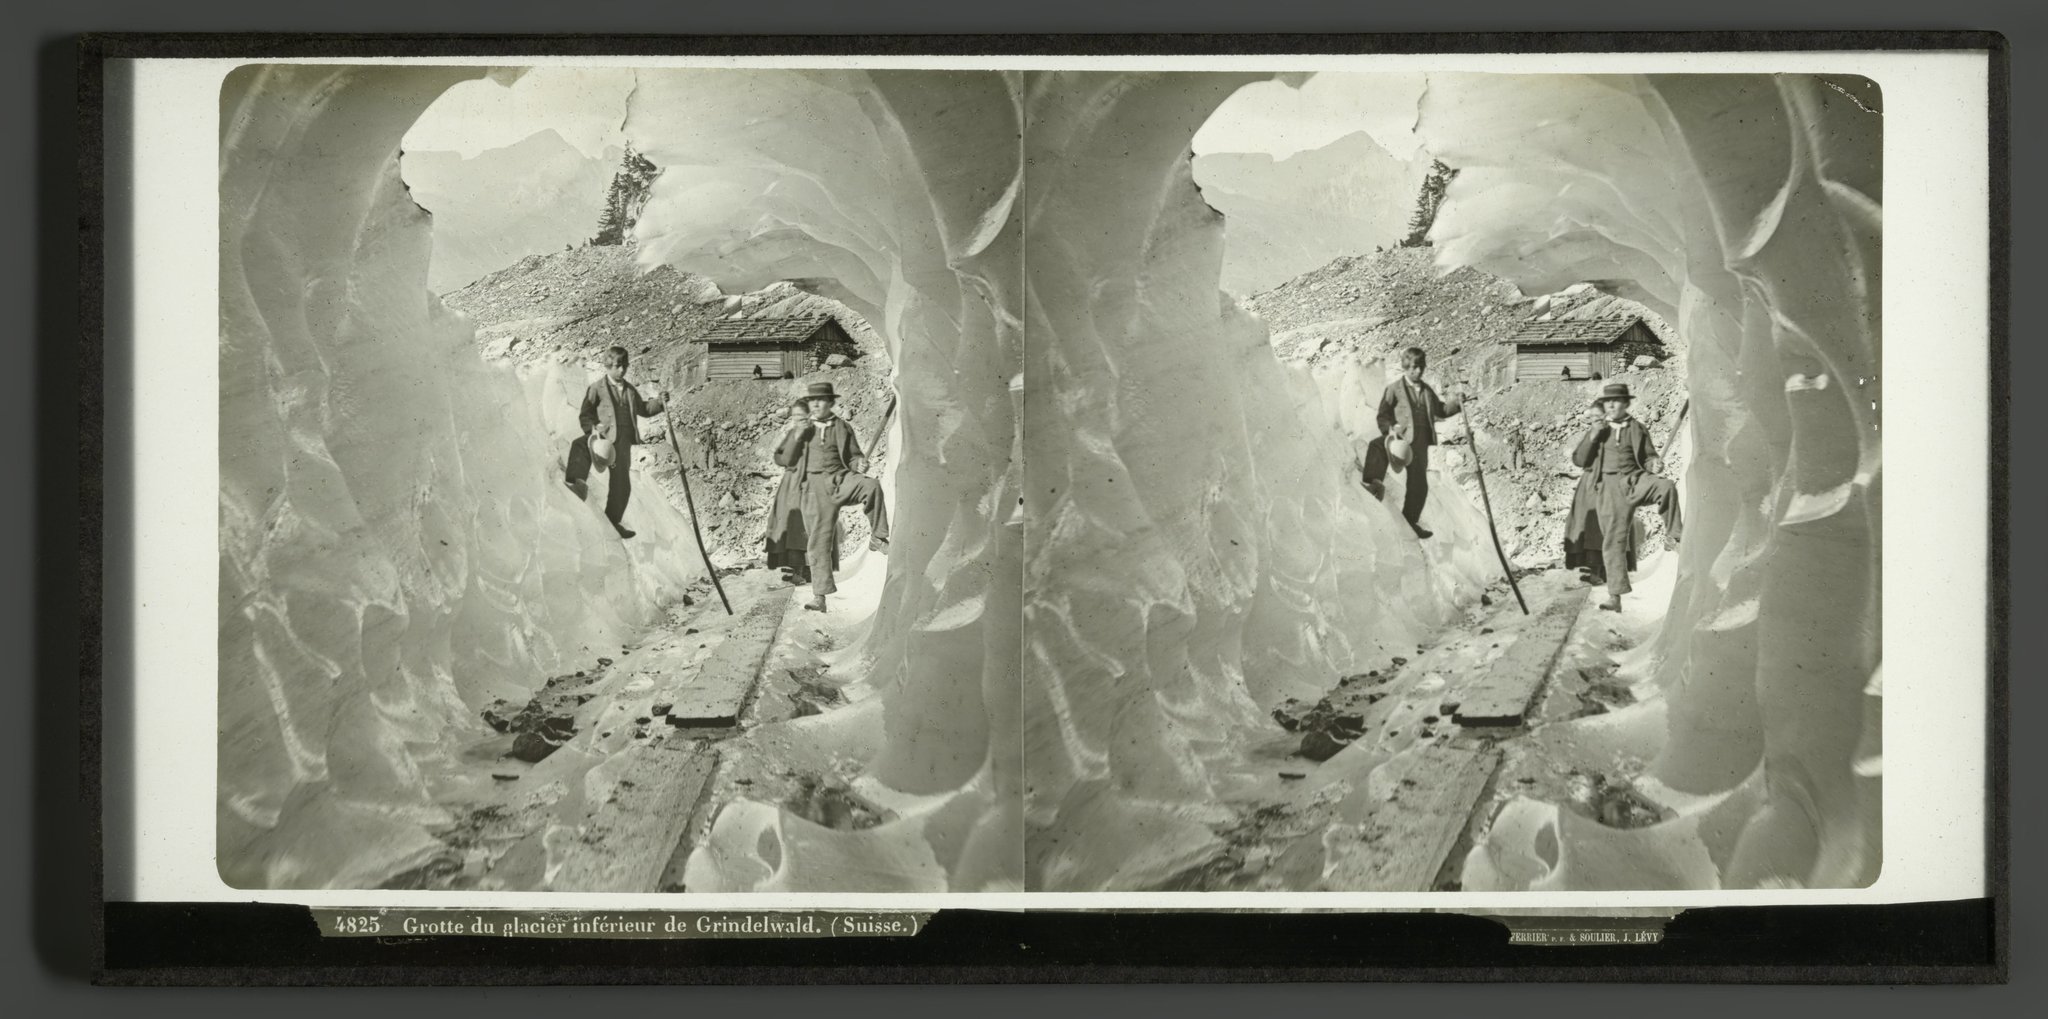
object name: stereoscopic photograph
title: Grotte du glacier inférieur de Grindelwald. (Suisse.)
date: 1860-1870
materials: glass, paper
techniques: slide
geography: grindelwald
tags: glacier (+ landscape with figures, staffage), cave, grotto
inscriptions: number: ‘4825’